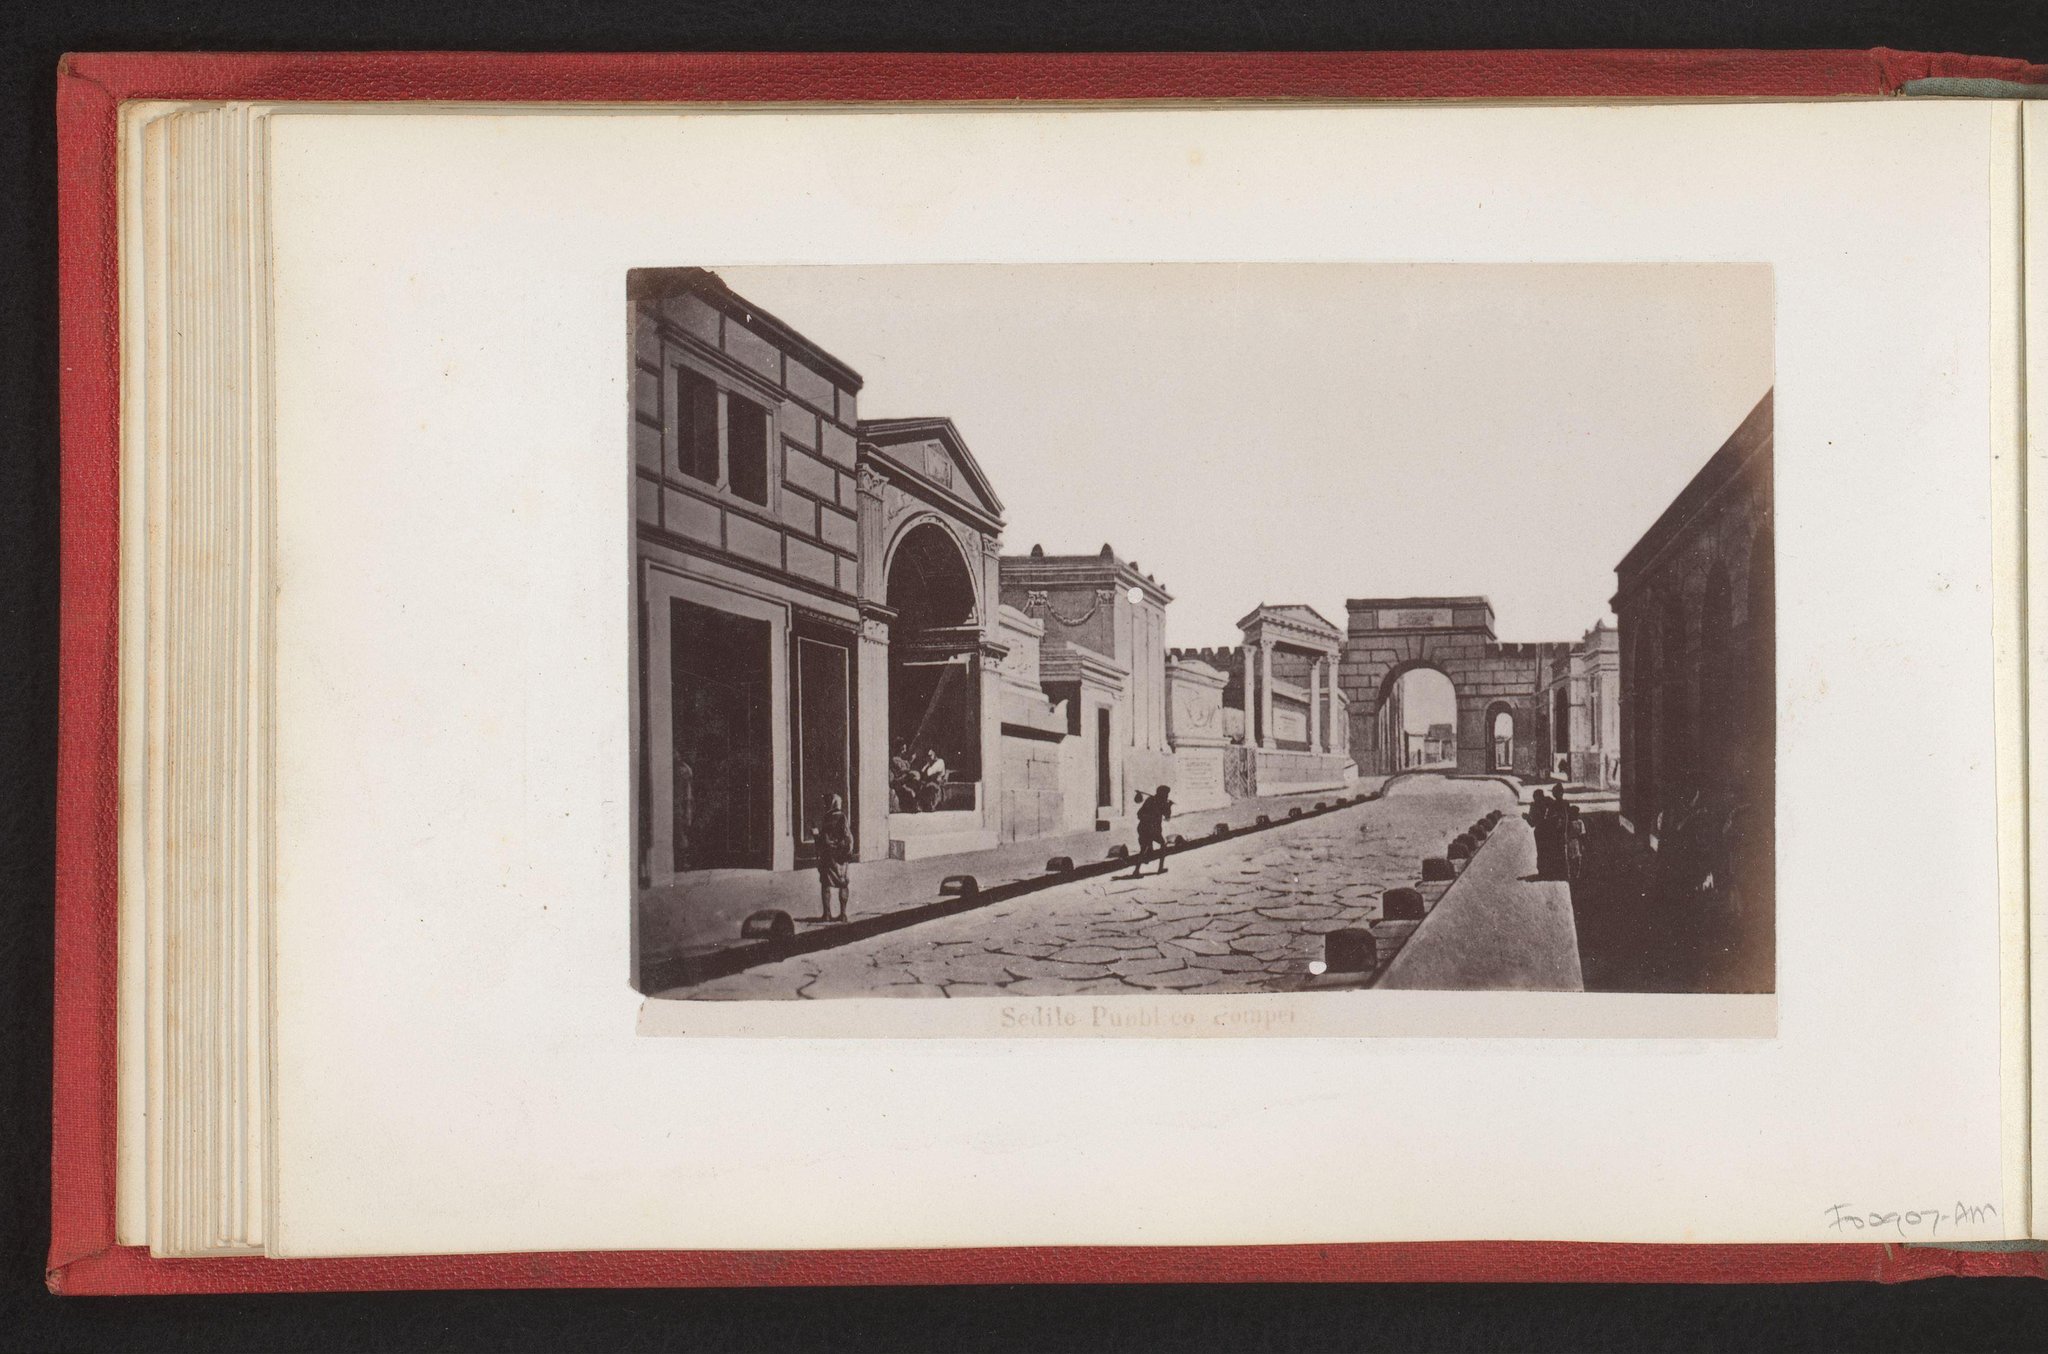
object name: reproduction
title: Fotoreproductie van een straatgezicht te Pompeï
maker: Anonymous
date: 1860-1900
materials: photographic support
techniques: albumen print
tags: the graphic arts, street